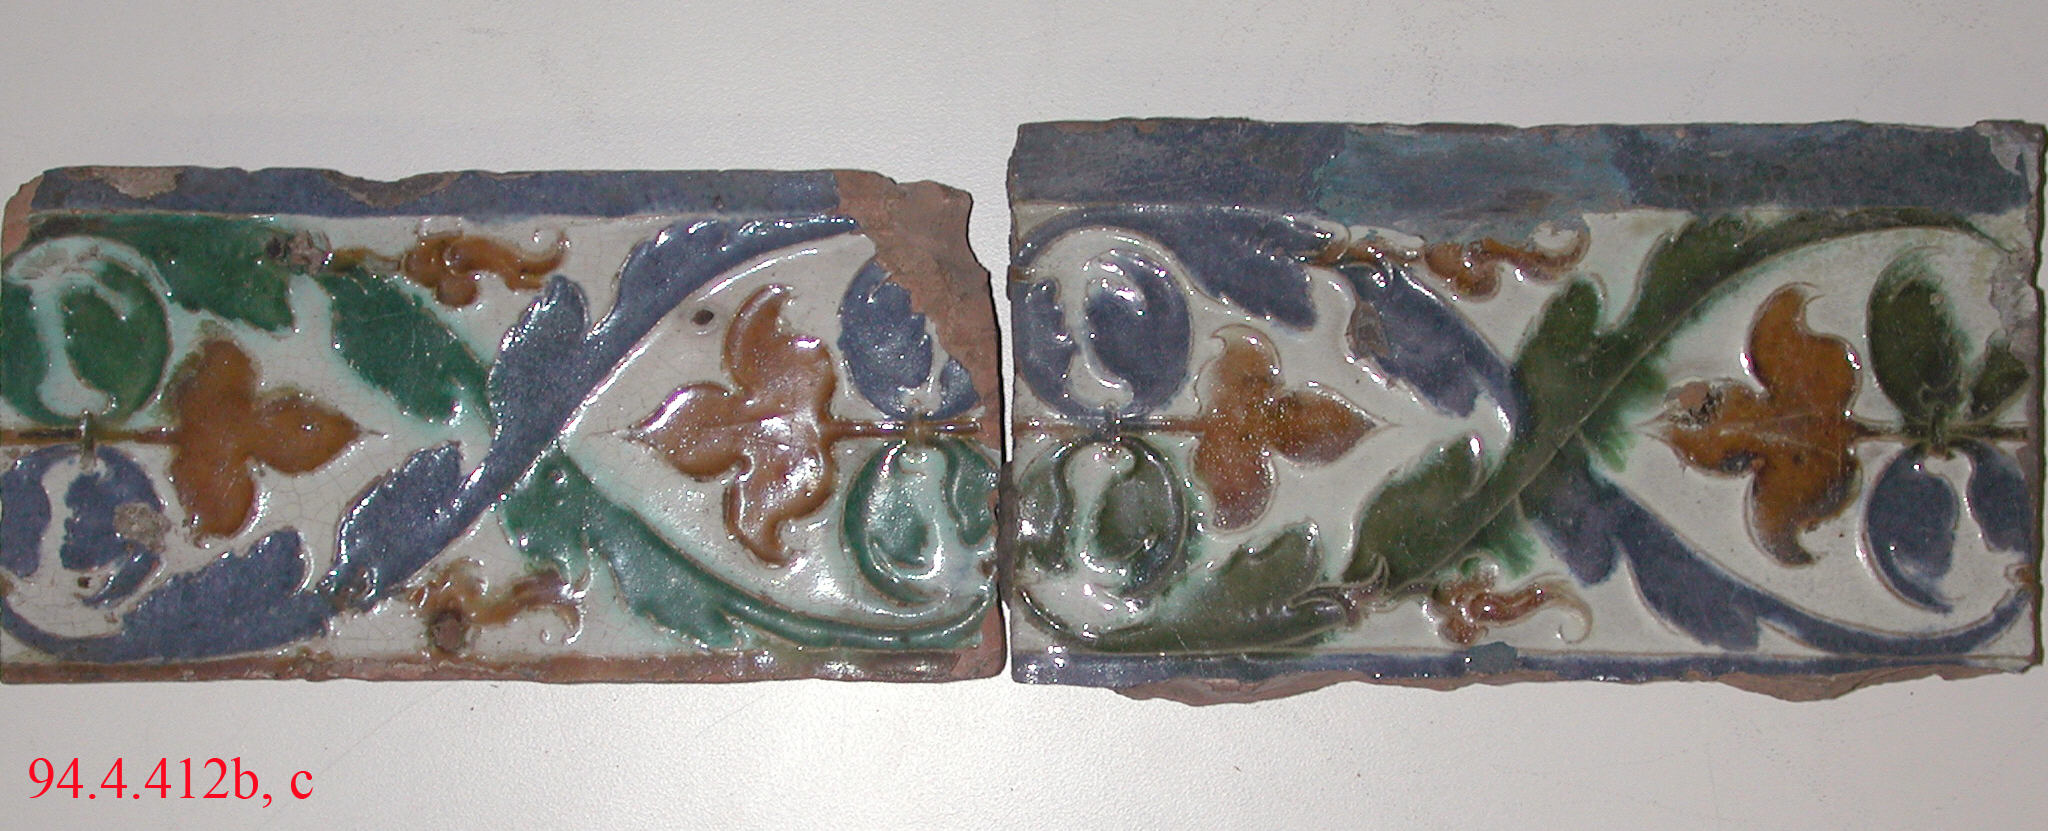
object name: wall tile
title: Wall tiles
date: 1501-1600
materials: earthenware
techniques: glazing